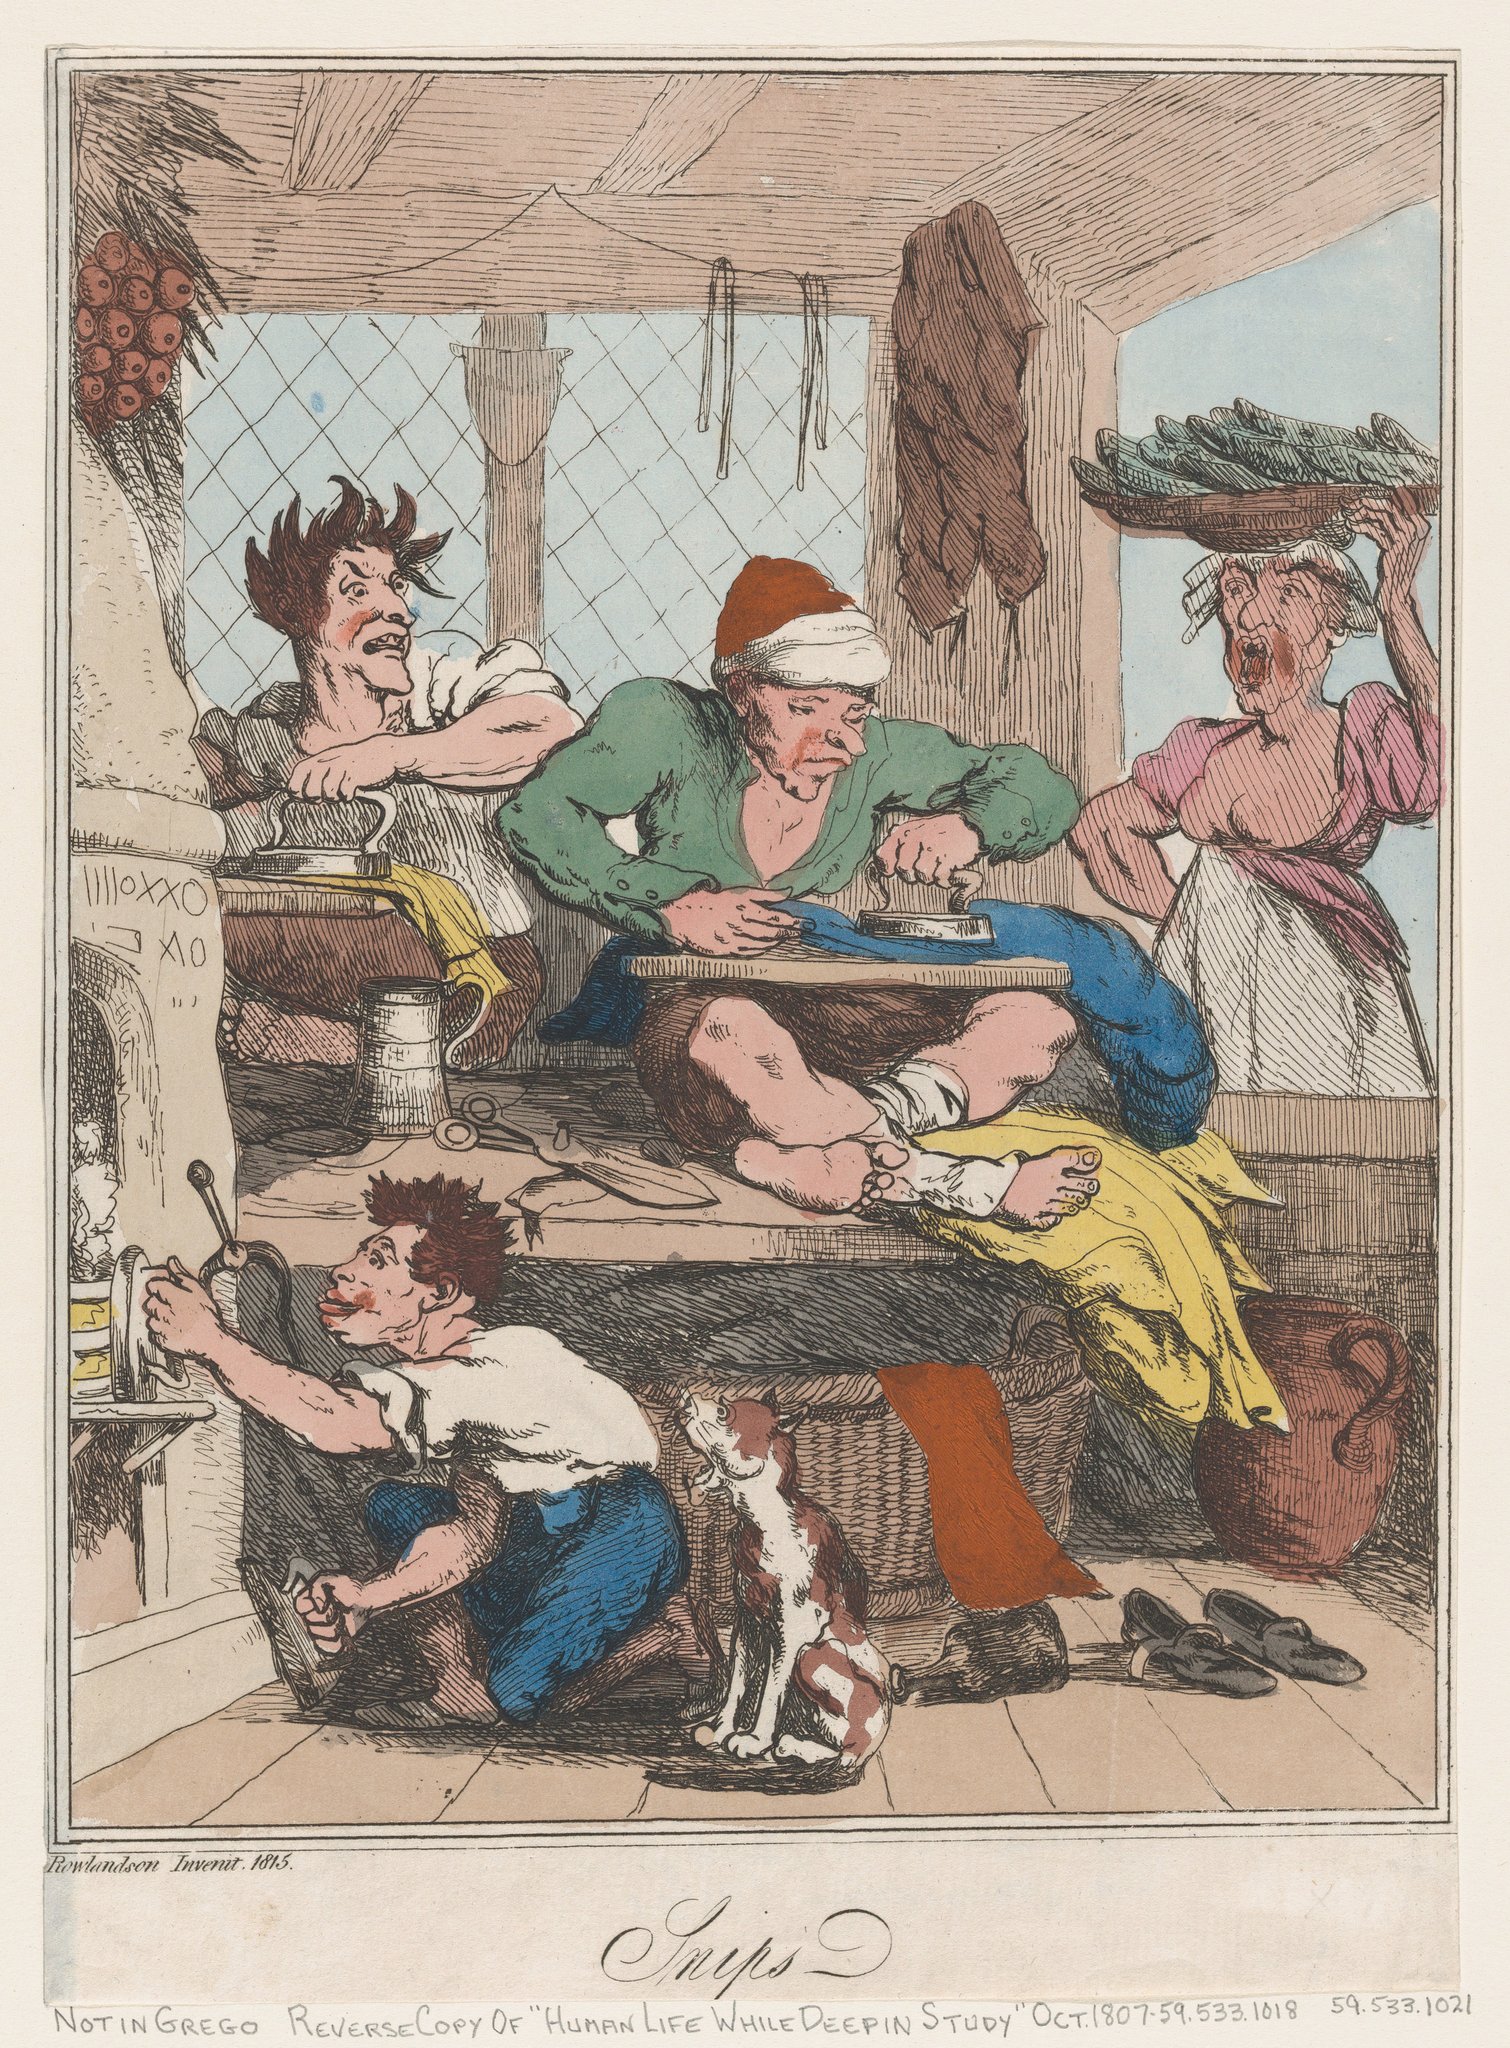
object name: print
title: Snips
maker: thomas rowlandson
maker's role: artist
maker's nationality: british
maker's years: 1757-1827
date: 1815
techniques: etching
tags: satire,men,women,dogs,working